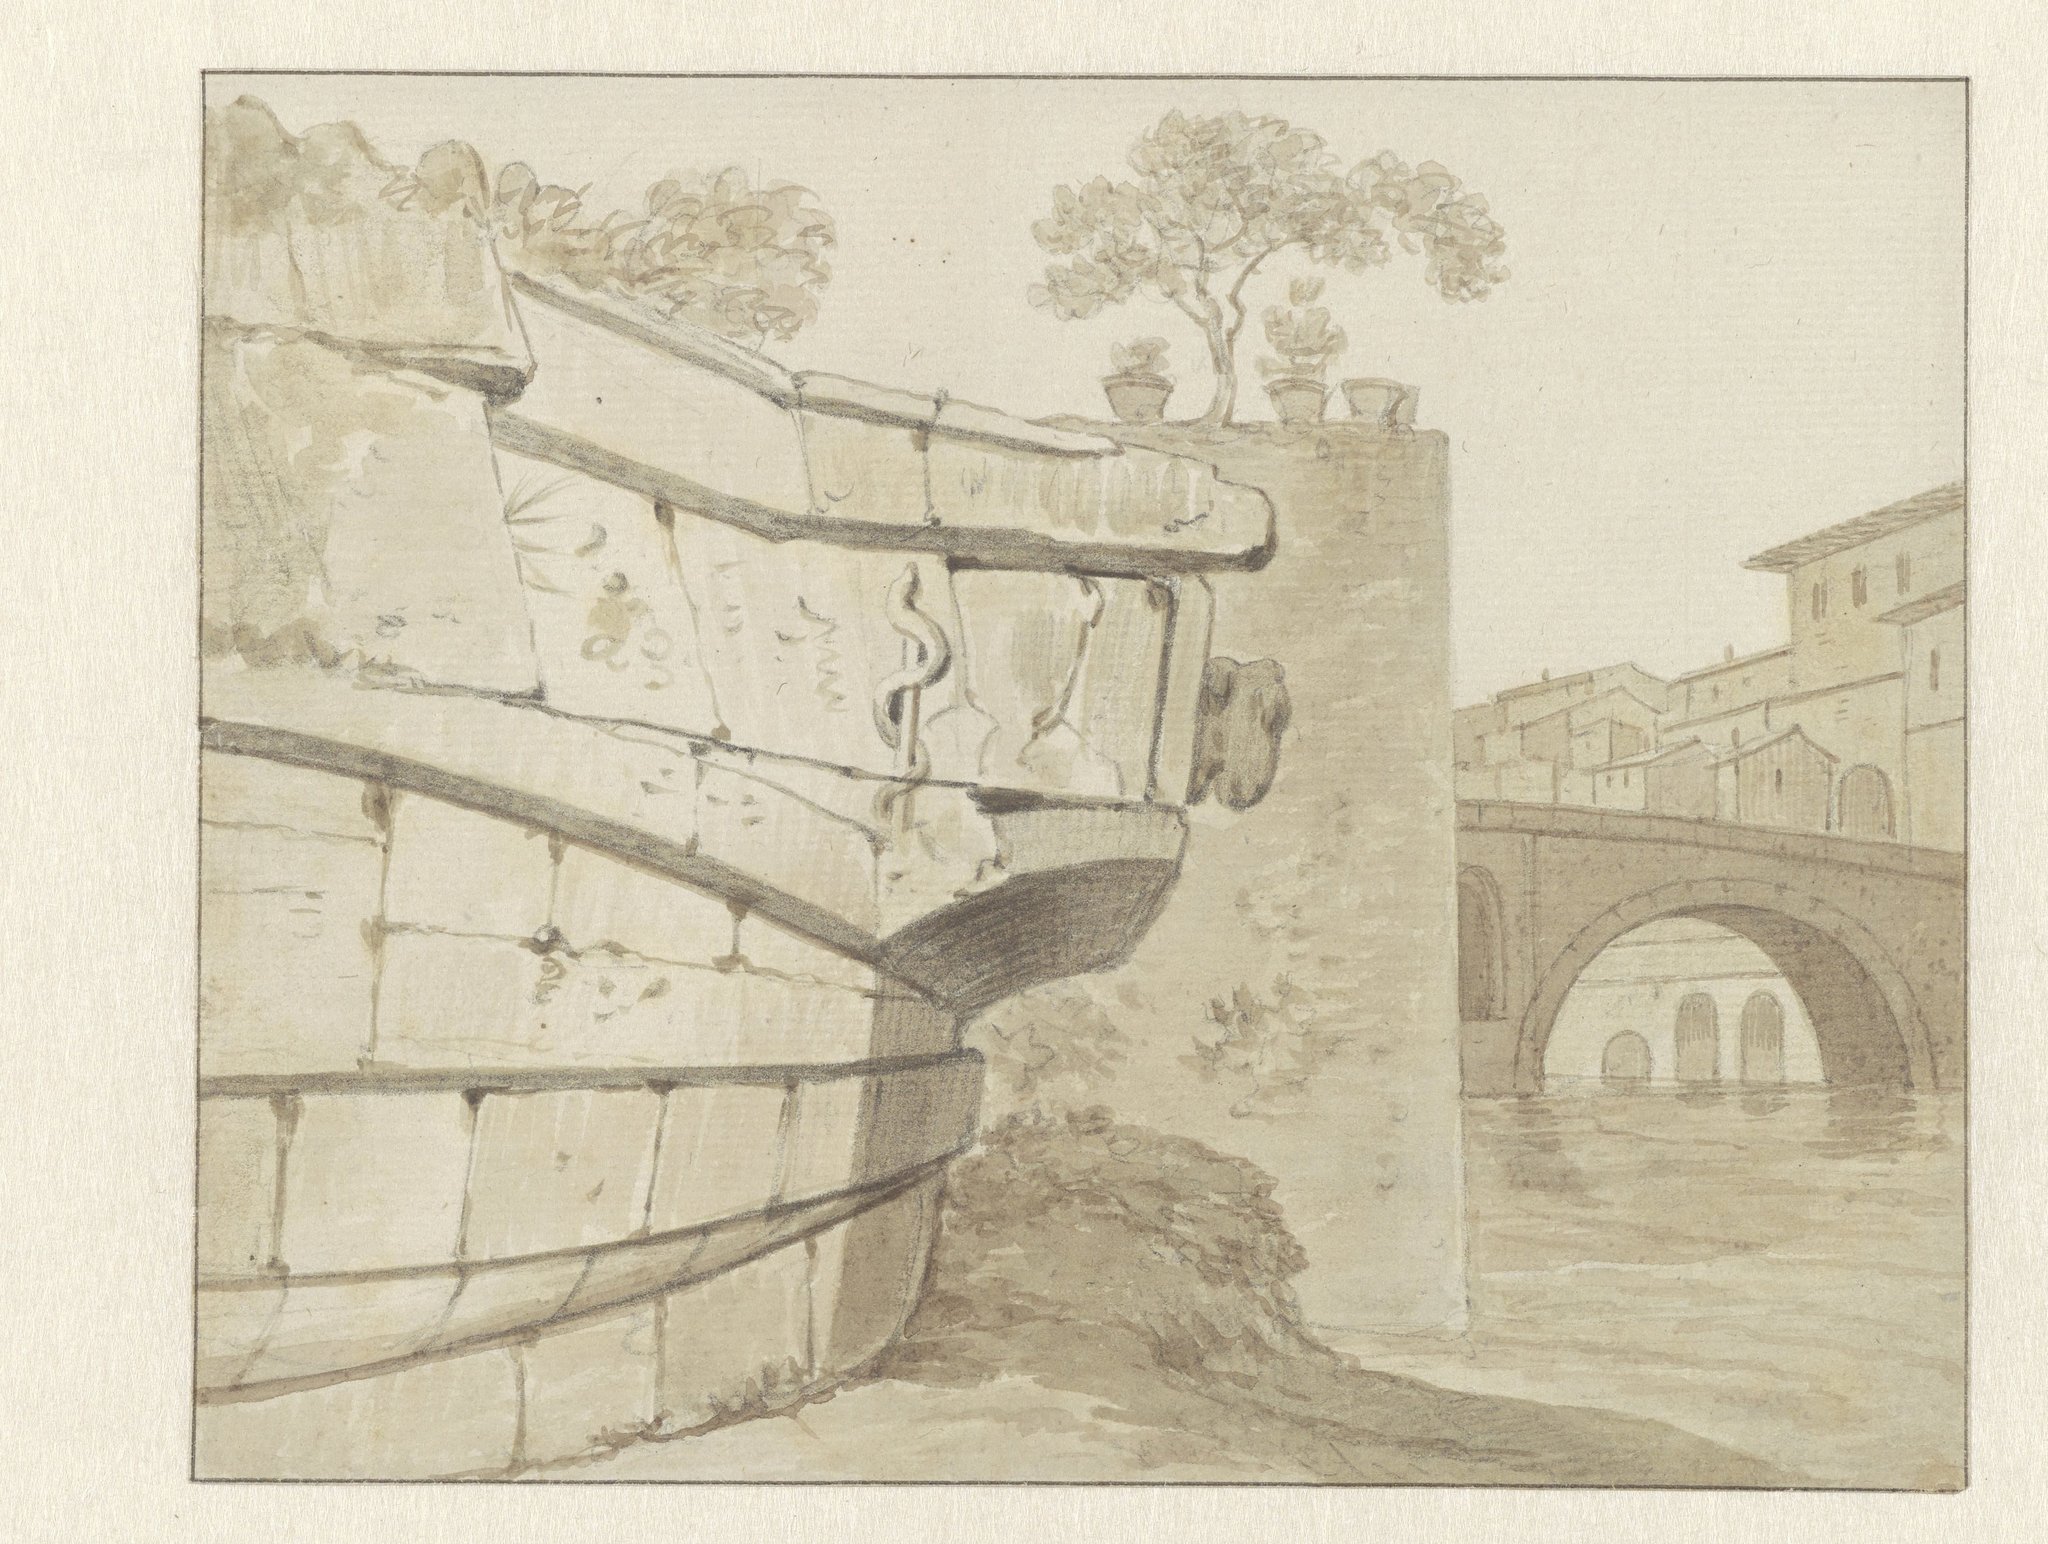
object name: drawing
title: Het Isola San Bartolommeo met de Ponte Quattro Capi, voorheen de Pons Fabricius, Rome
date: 1761-1817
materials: graphite, ink, paper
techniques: brush, pen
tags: city-view in general; 'veduta', bridge in city across river, canal, etc.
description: Tekening uit een groep tekeningen van landschappen en stadsgezichten in Italië (Rome, Tivoli, Civita Castellana en Pozzuoli).